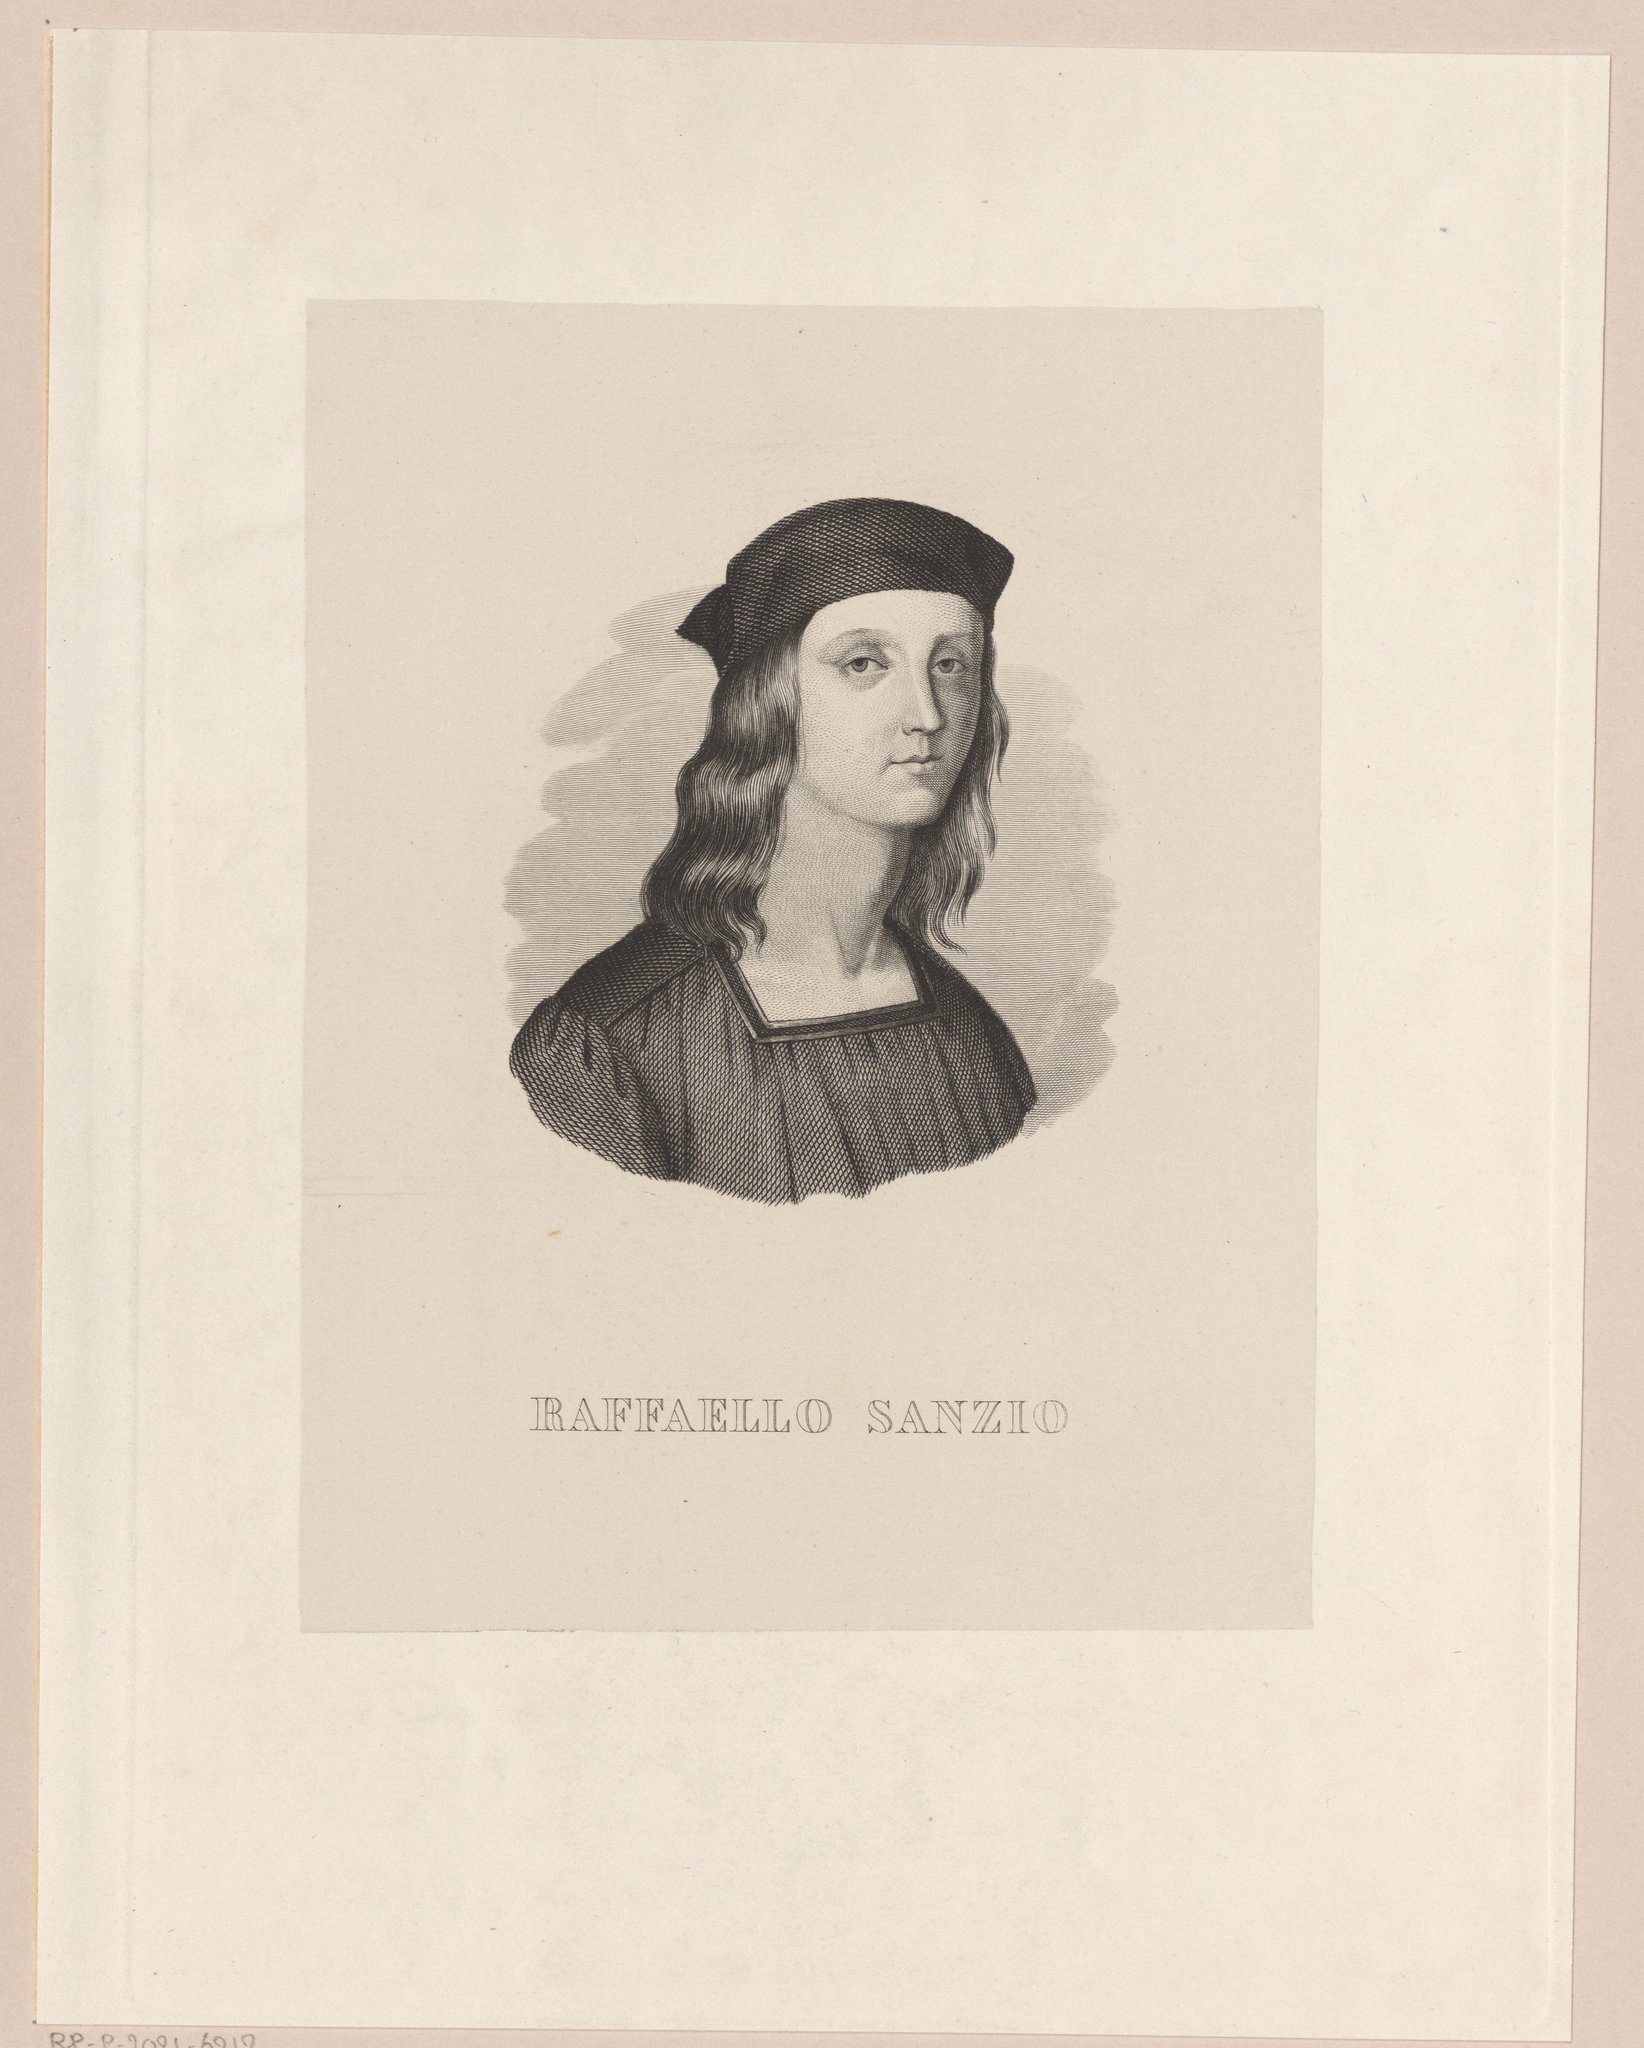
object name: print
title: Portret van Rafaël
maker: Anonymous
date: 1700-1849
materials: paper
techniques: engraving, etching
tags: rome, painter, rafaël, historical persons